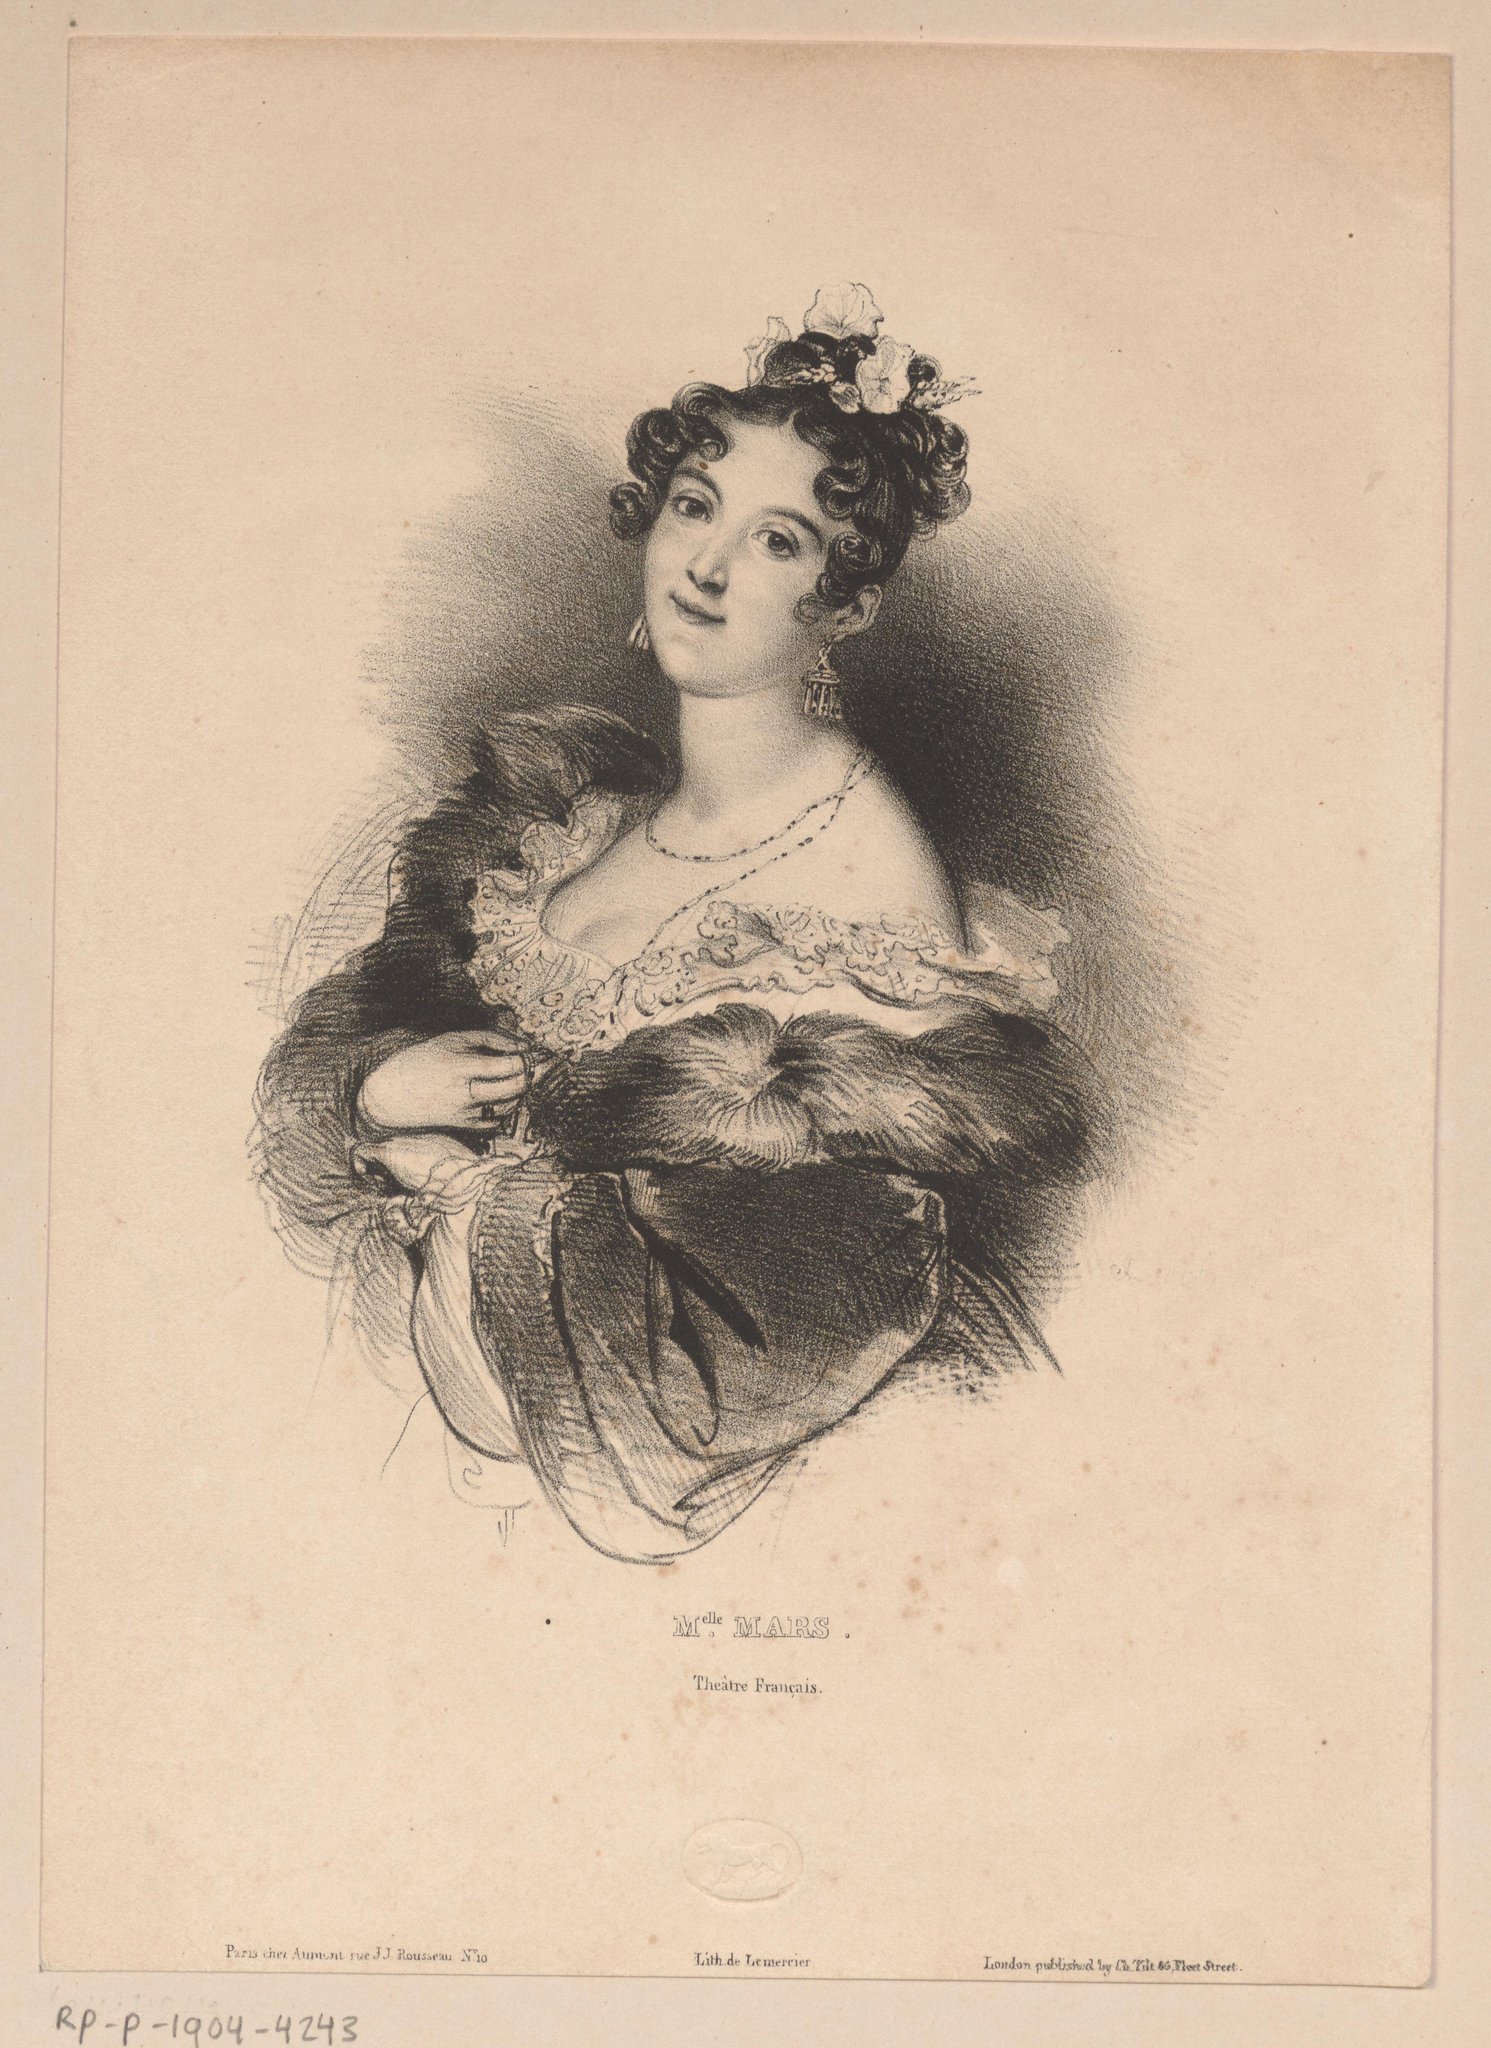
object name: print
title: Actrices des principaux Théatres de Paris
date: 1831-1832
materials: paper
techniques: lithograph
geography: france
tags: paris, historical persons - bb - woman, portrait of actor, actress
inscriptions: check stamp: Lugt 4965, collector's mark: Lugt 2228